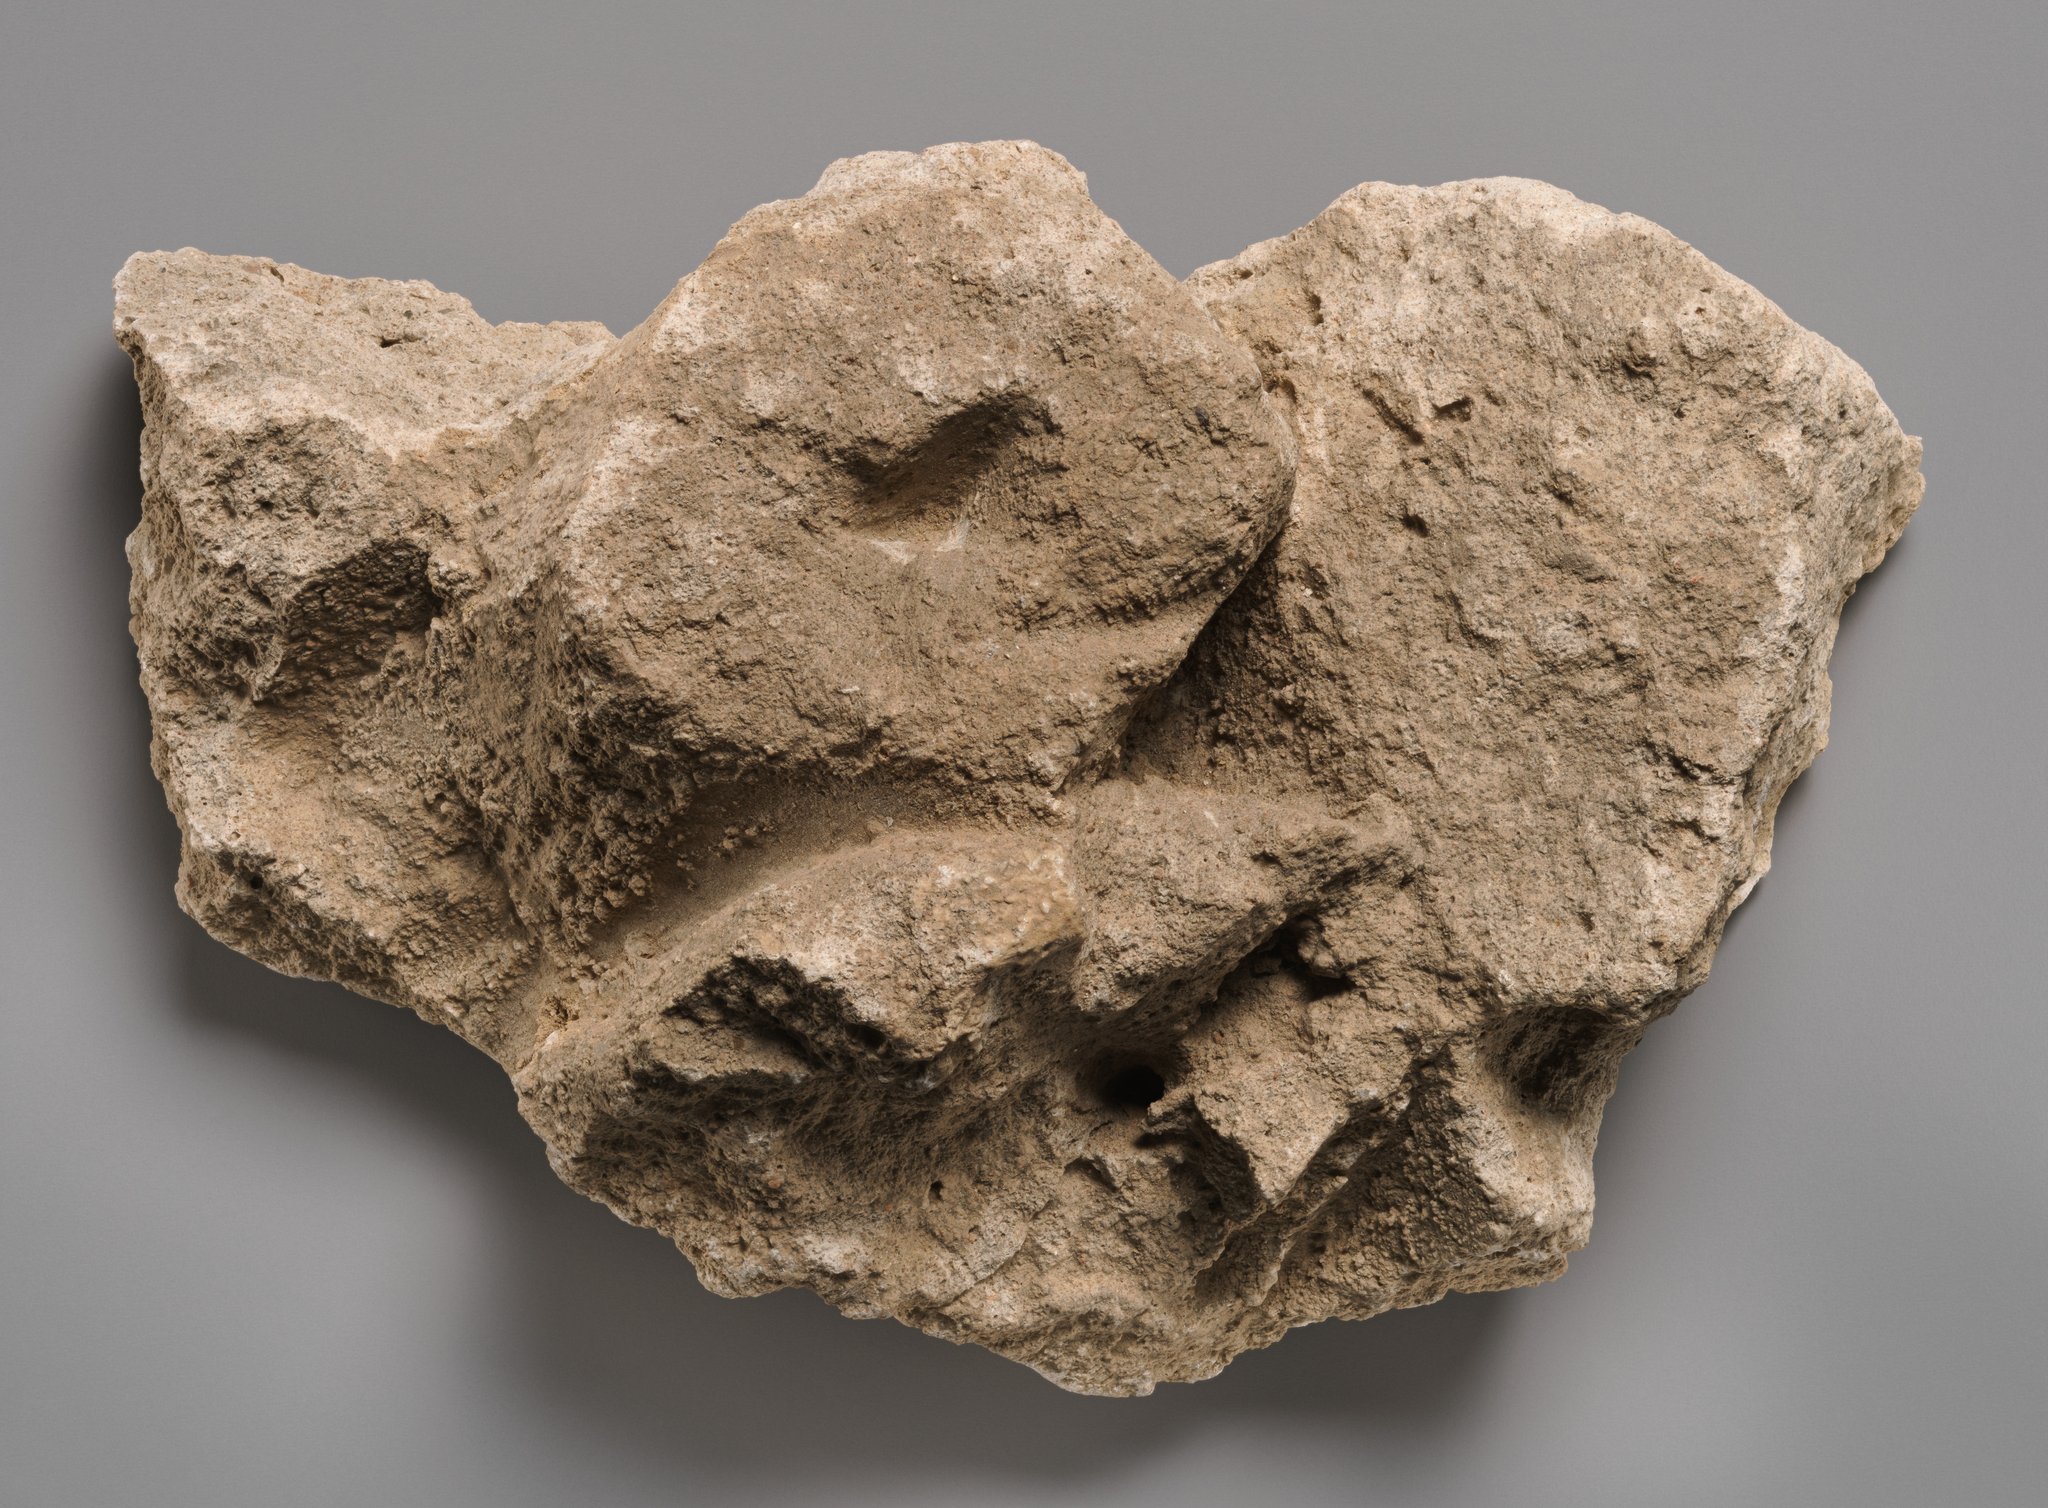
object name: relief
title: Relief fragment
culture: sasanian or islamic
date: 501-800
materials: plaster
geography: mesopotamia